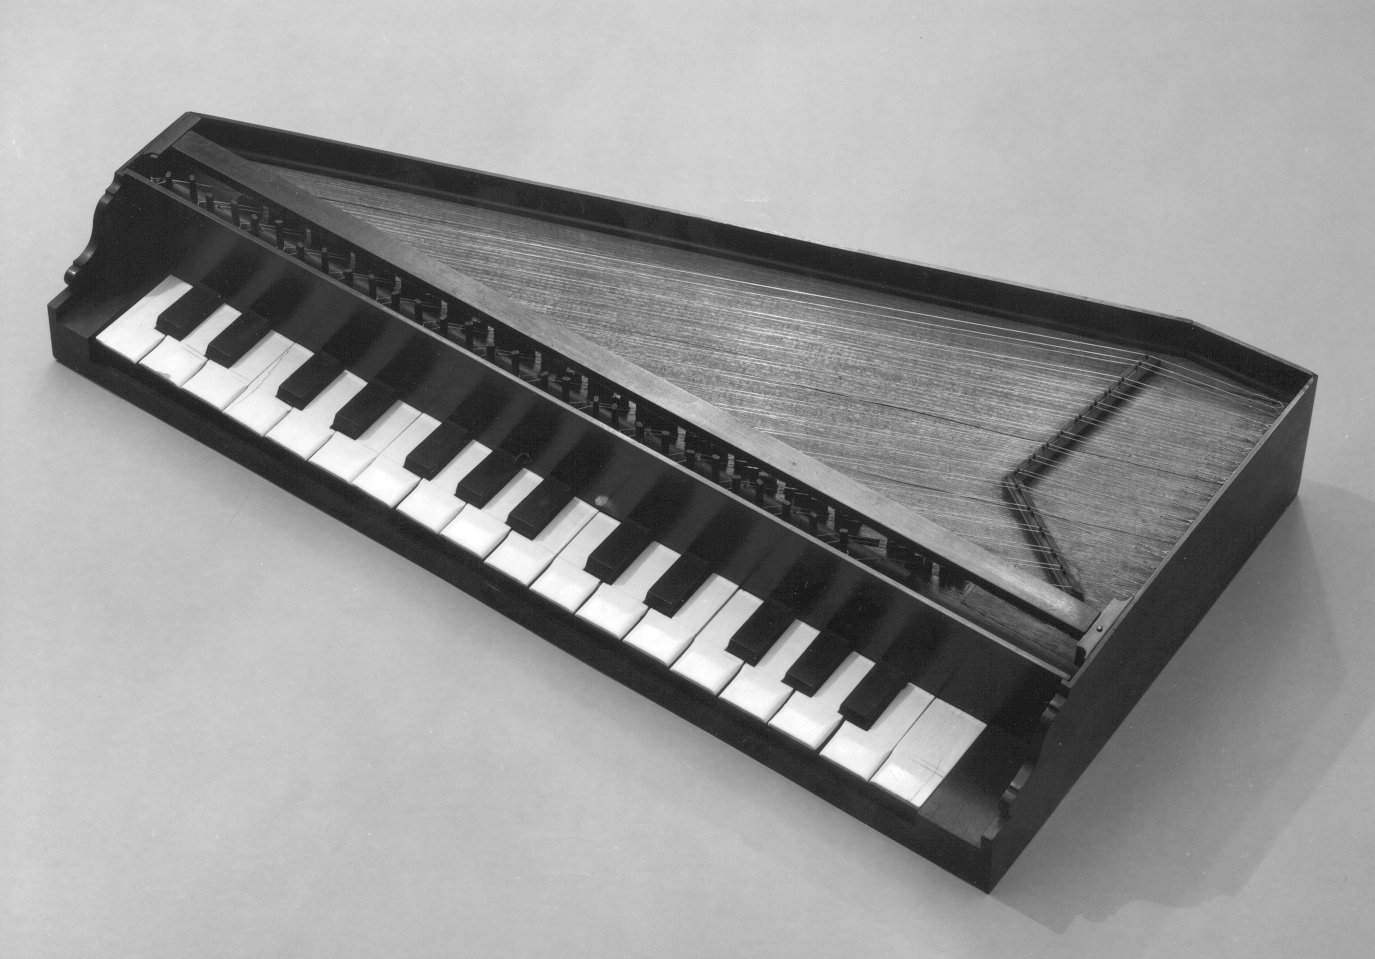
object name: triangular octave spinet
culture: italian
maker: girolamo zenti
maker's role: maker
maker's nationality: italian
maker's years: 1609-1667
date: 1668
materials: wood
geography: italy